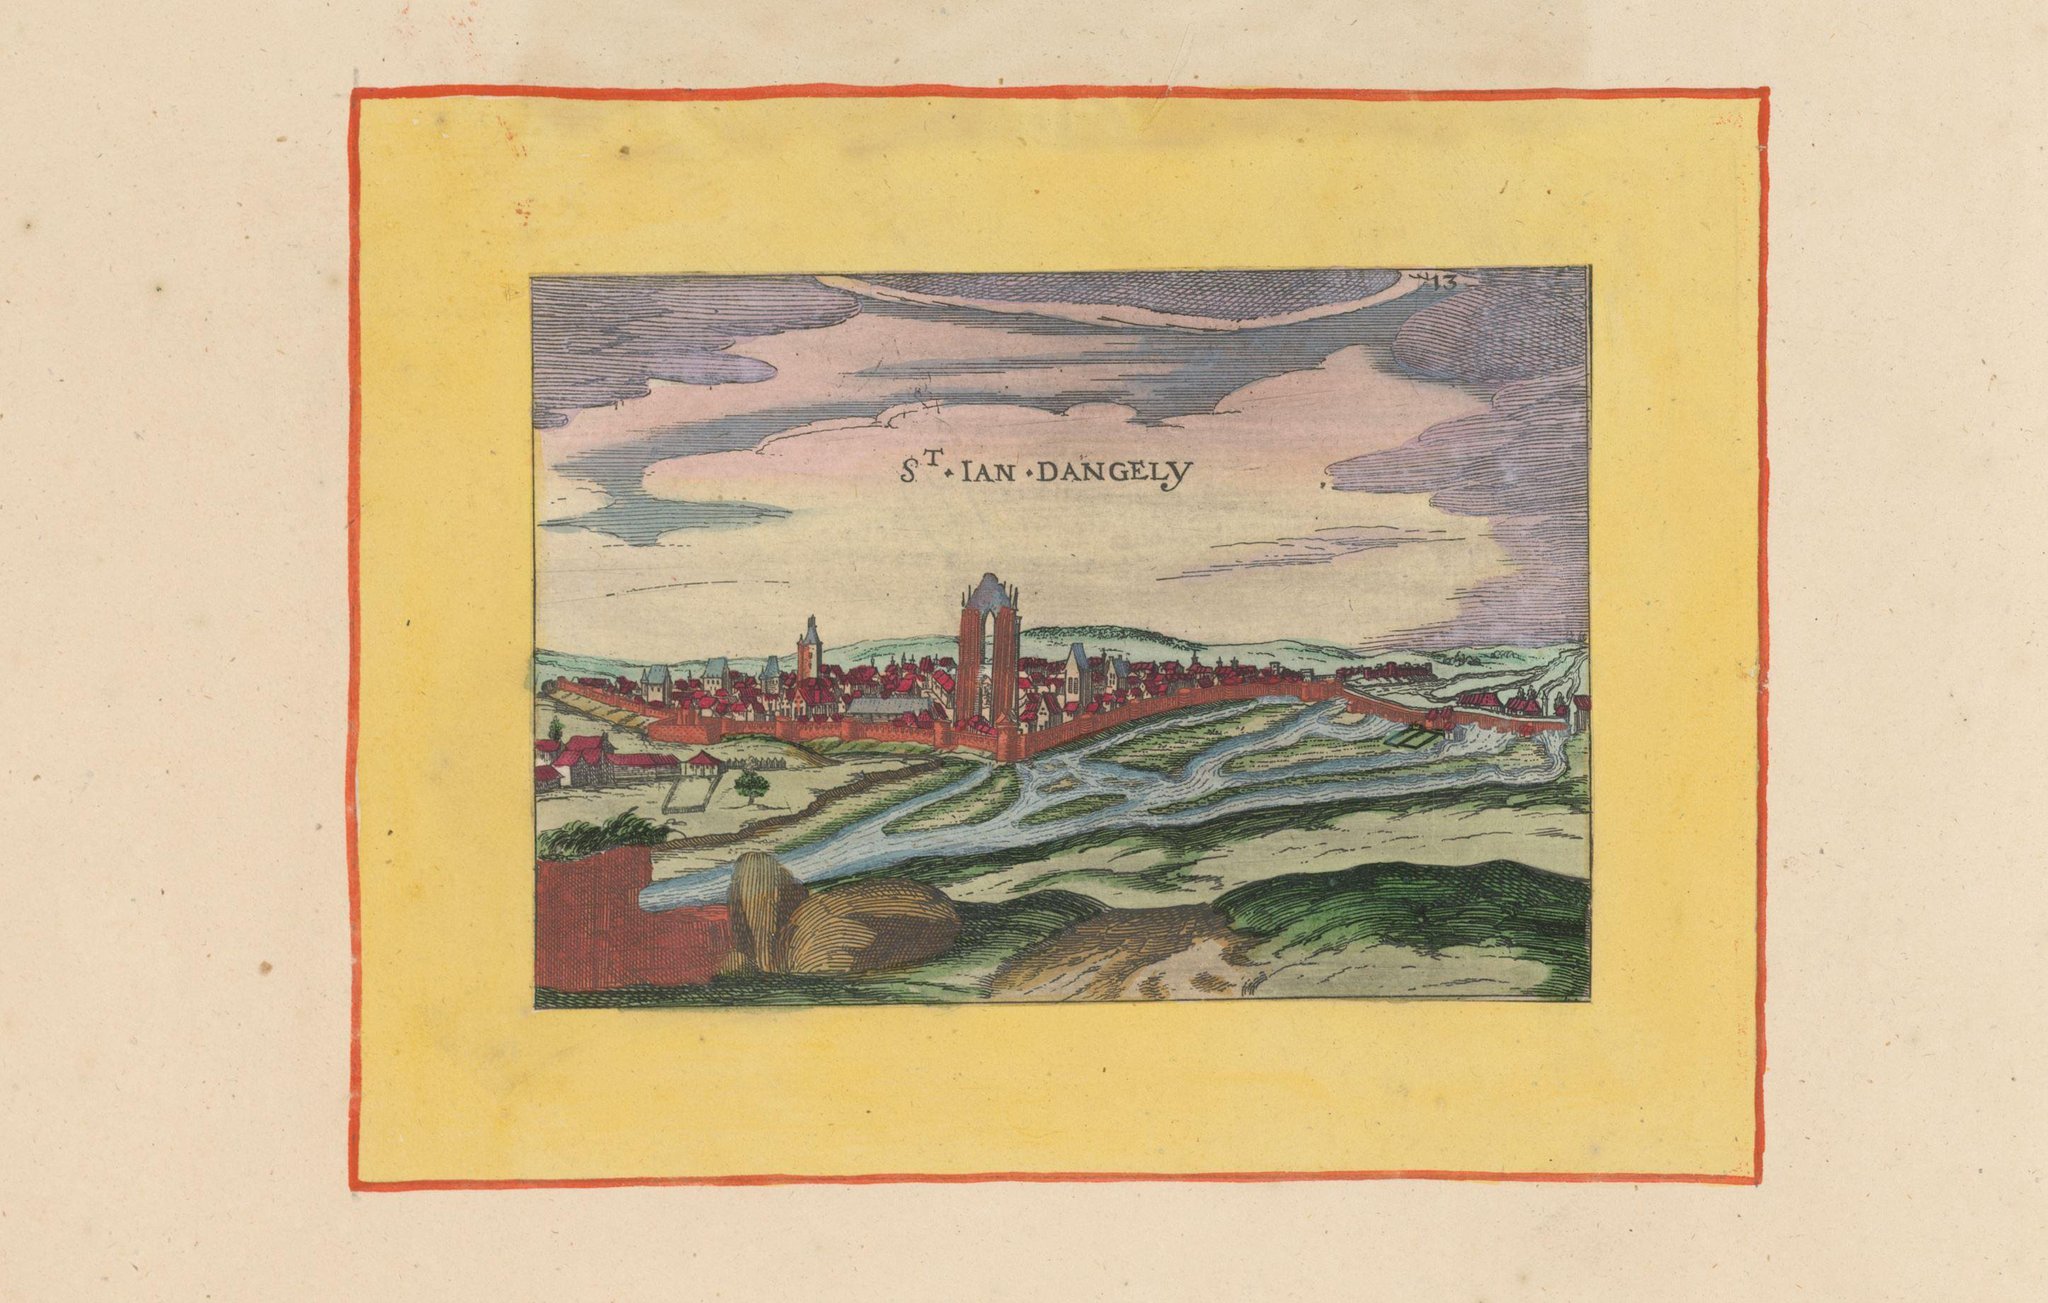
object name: print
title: Gezicht op Saint-Jean-d'Angély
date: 1638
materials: paper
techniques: engraving, etching, hand coloring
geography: paris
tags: city-view in general; 'veduta'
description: Prent uit: Tassin, Christophe. Les plans et profils de toutes les principales villes et lieux considérables de France (...). Parijs: Michel van Lochom, 1638, prent 13 uit het deel 'Poictou'.